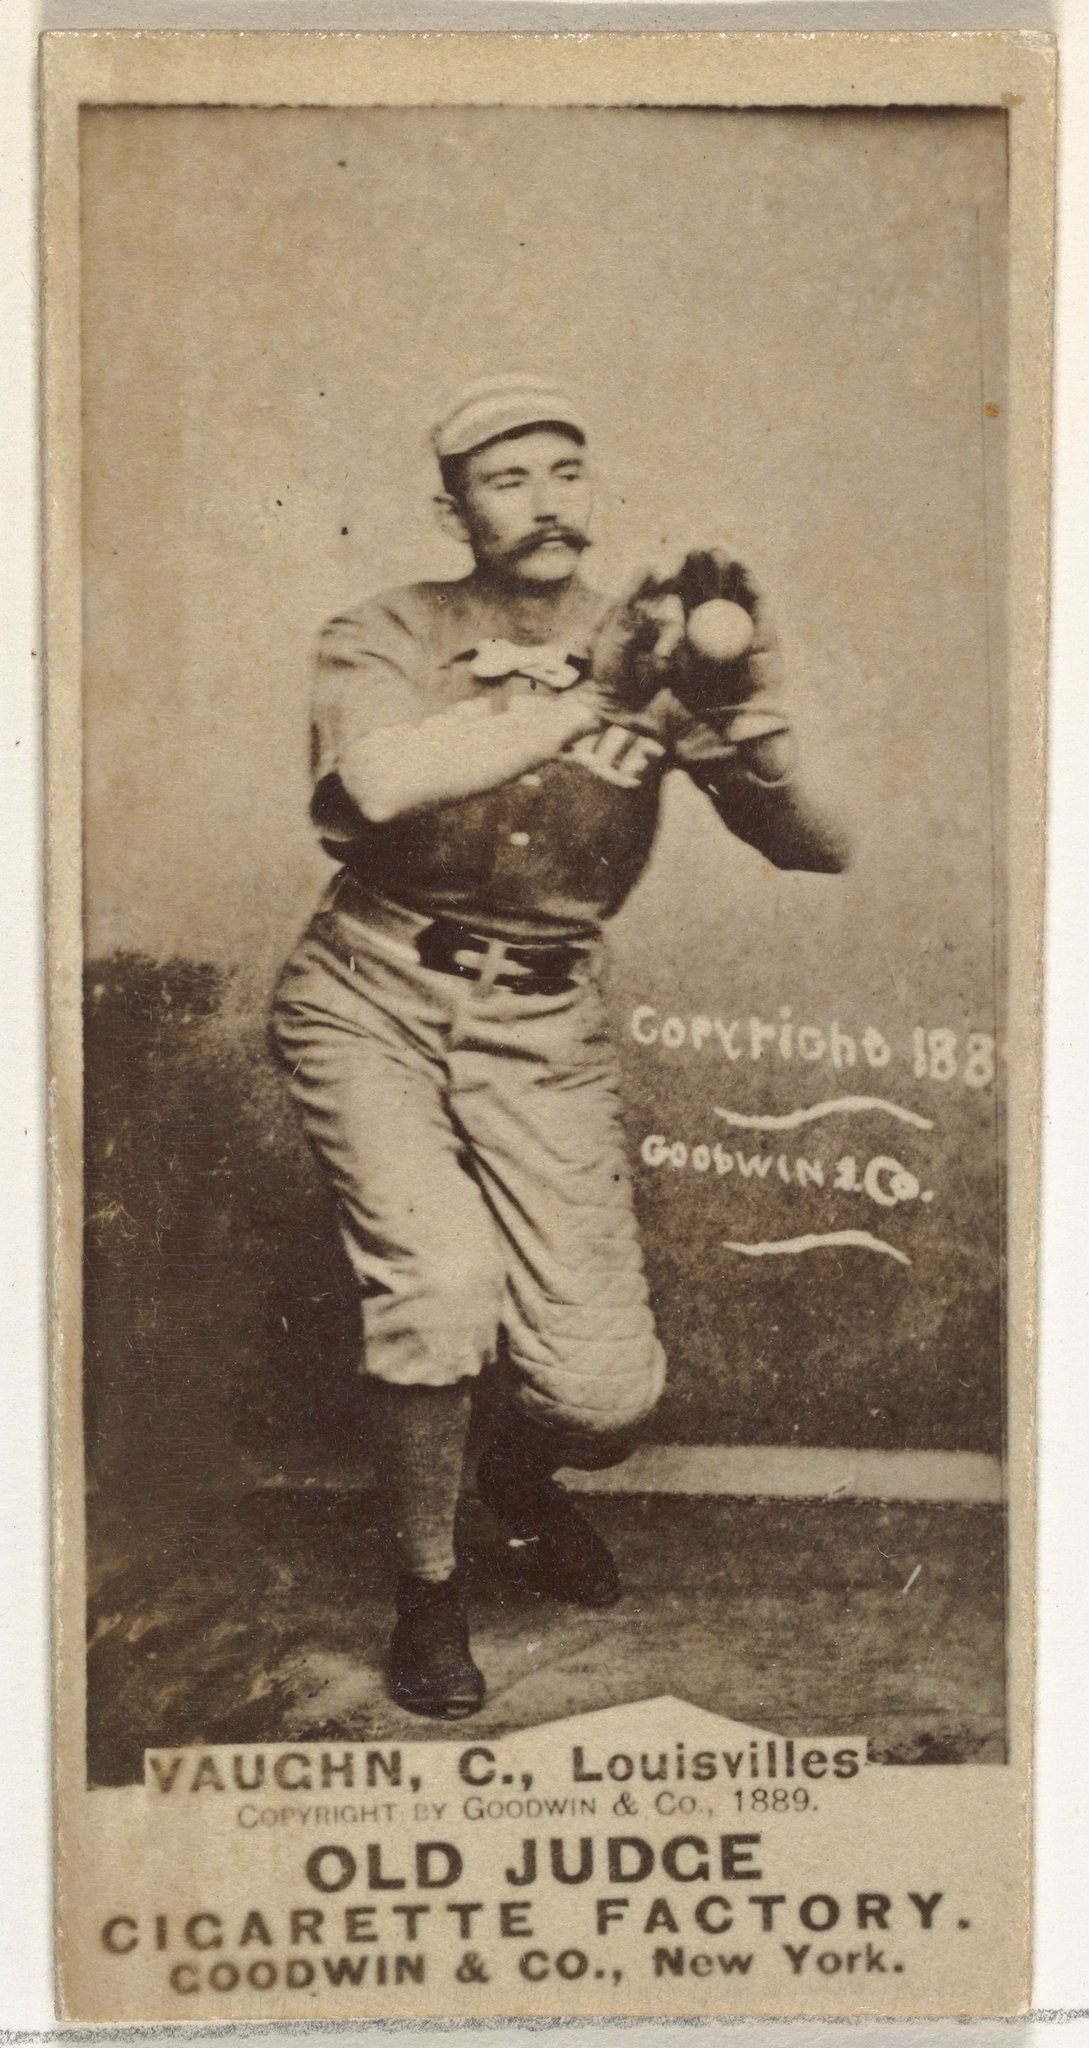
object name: baseball card, photograph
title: Harry Francis "Farmer" Vaughn, Catcher, Louisville Colonels, from the Old Judge series (N172) for Old Judge Cigarettes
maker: goodwin & company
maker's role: publisher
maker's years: 1850-1950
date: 1889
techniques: albumen silver print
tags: men,portraits,baseball,athletes